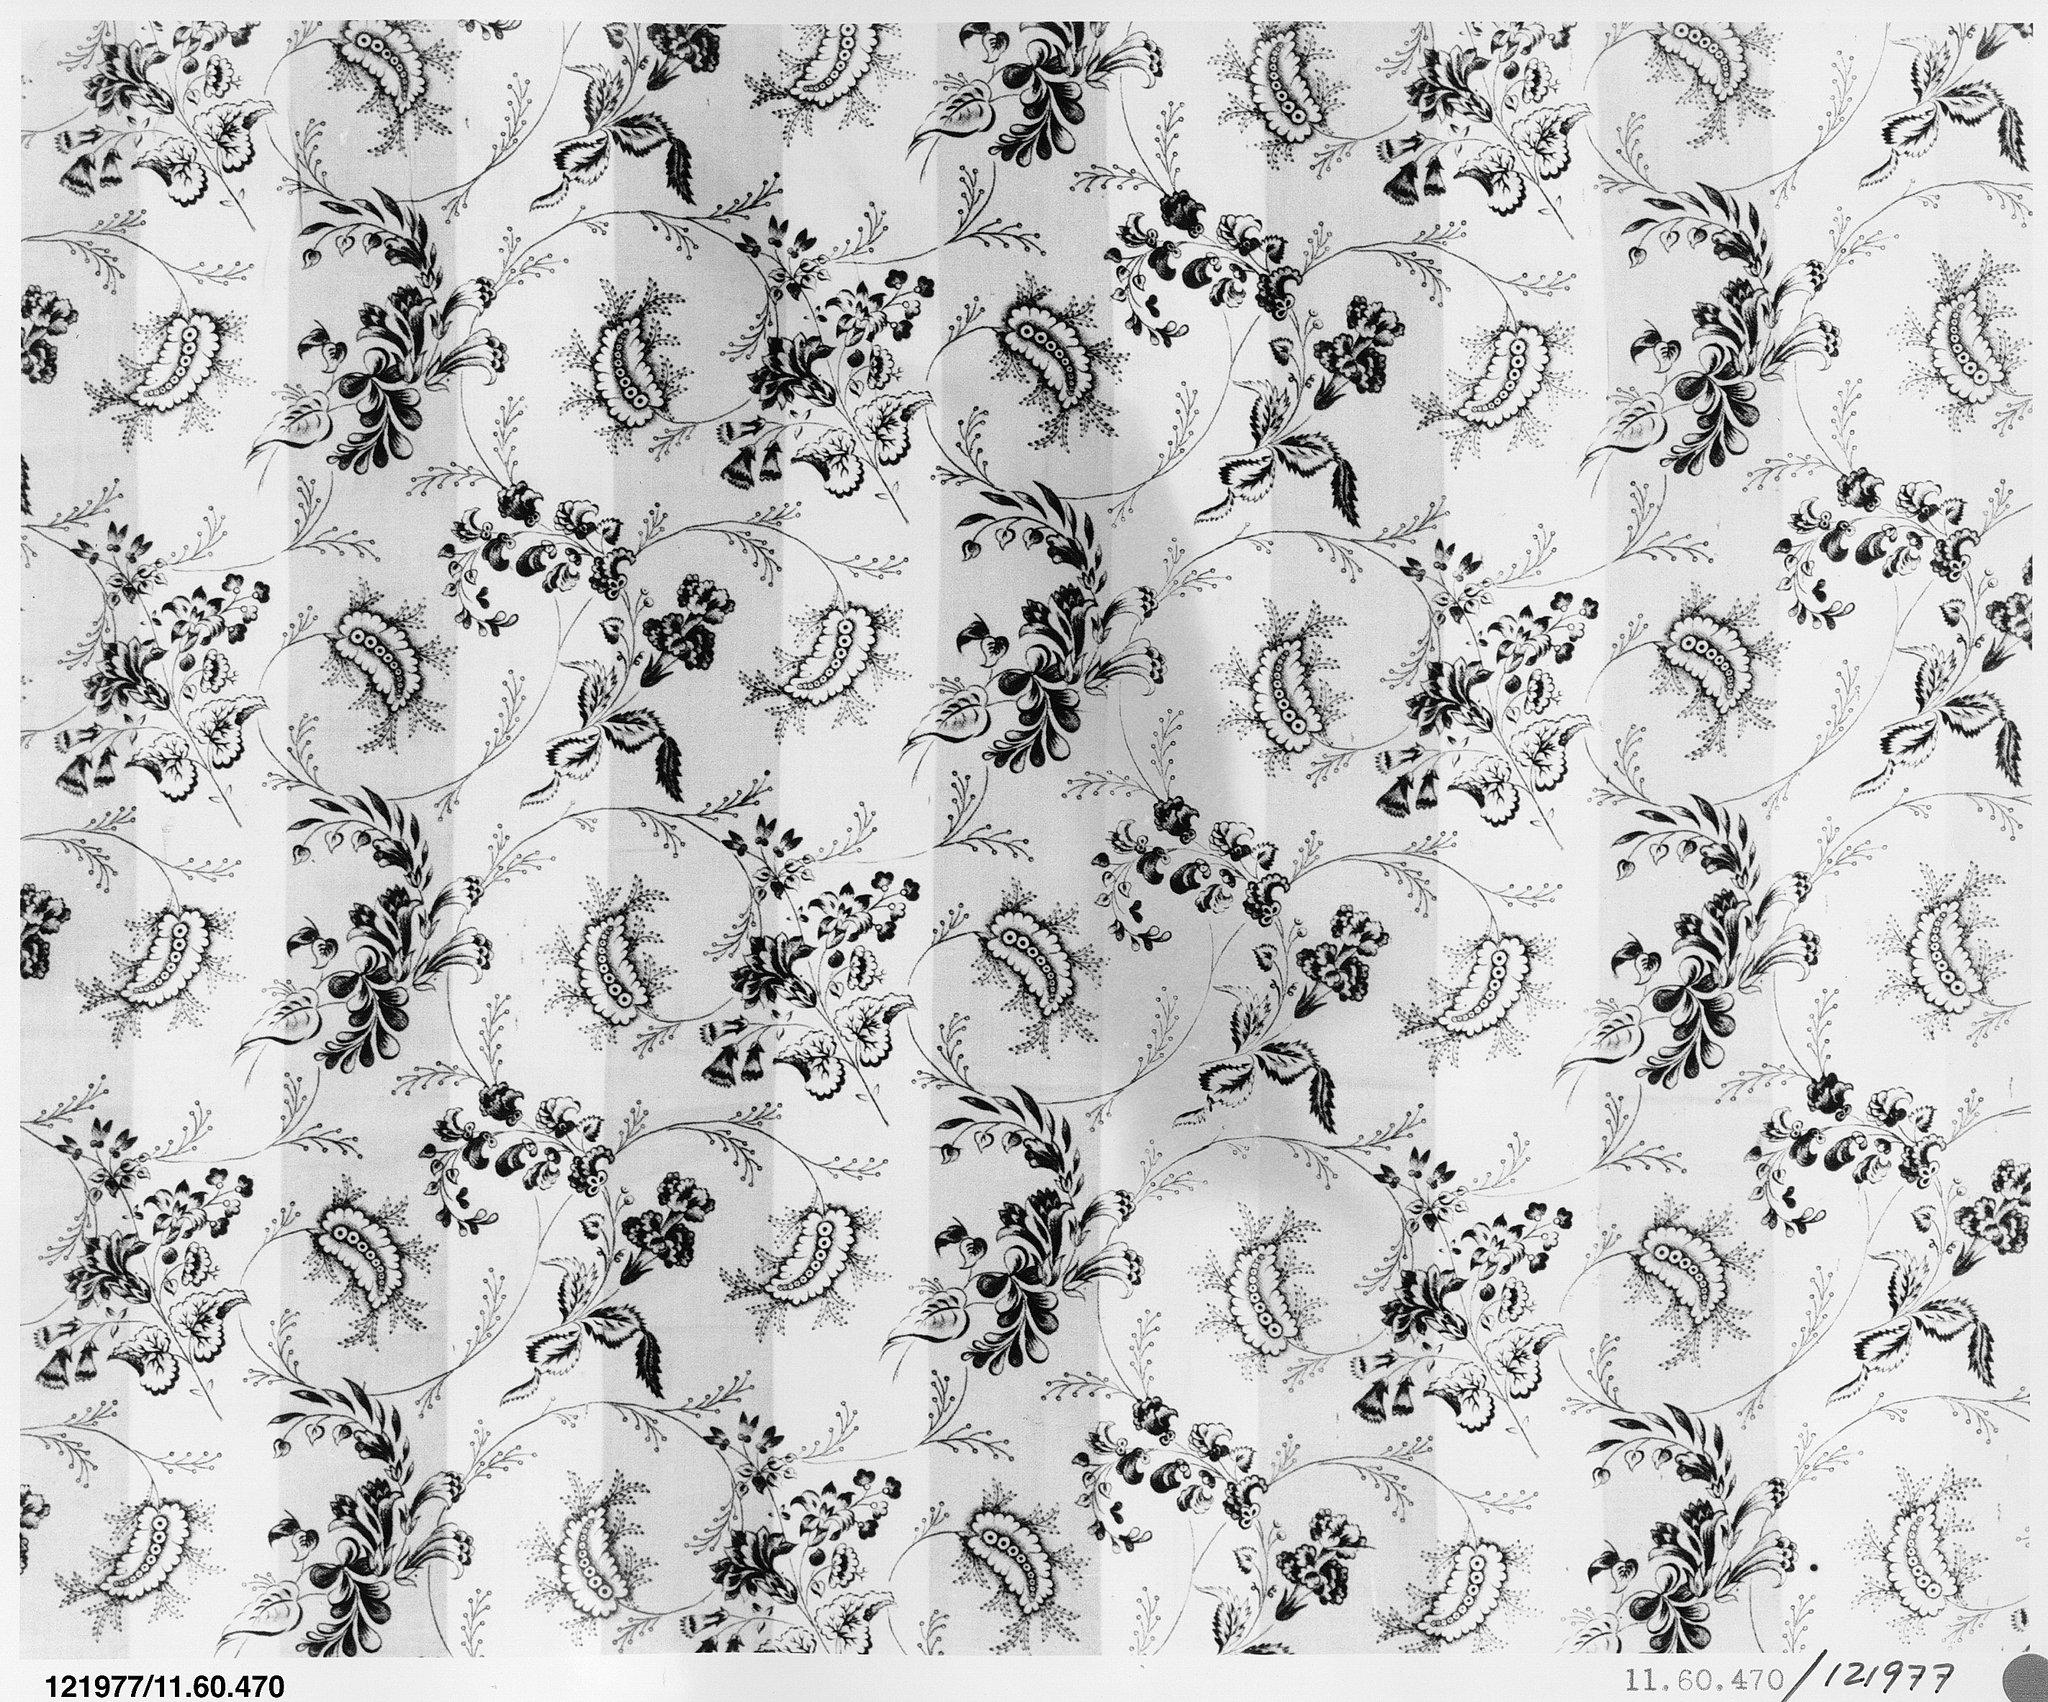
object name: printed piece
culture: american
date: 1835-1840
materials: cotton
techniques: printing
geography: united states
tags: flowers,leaves